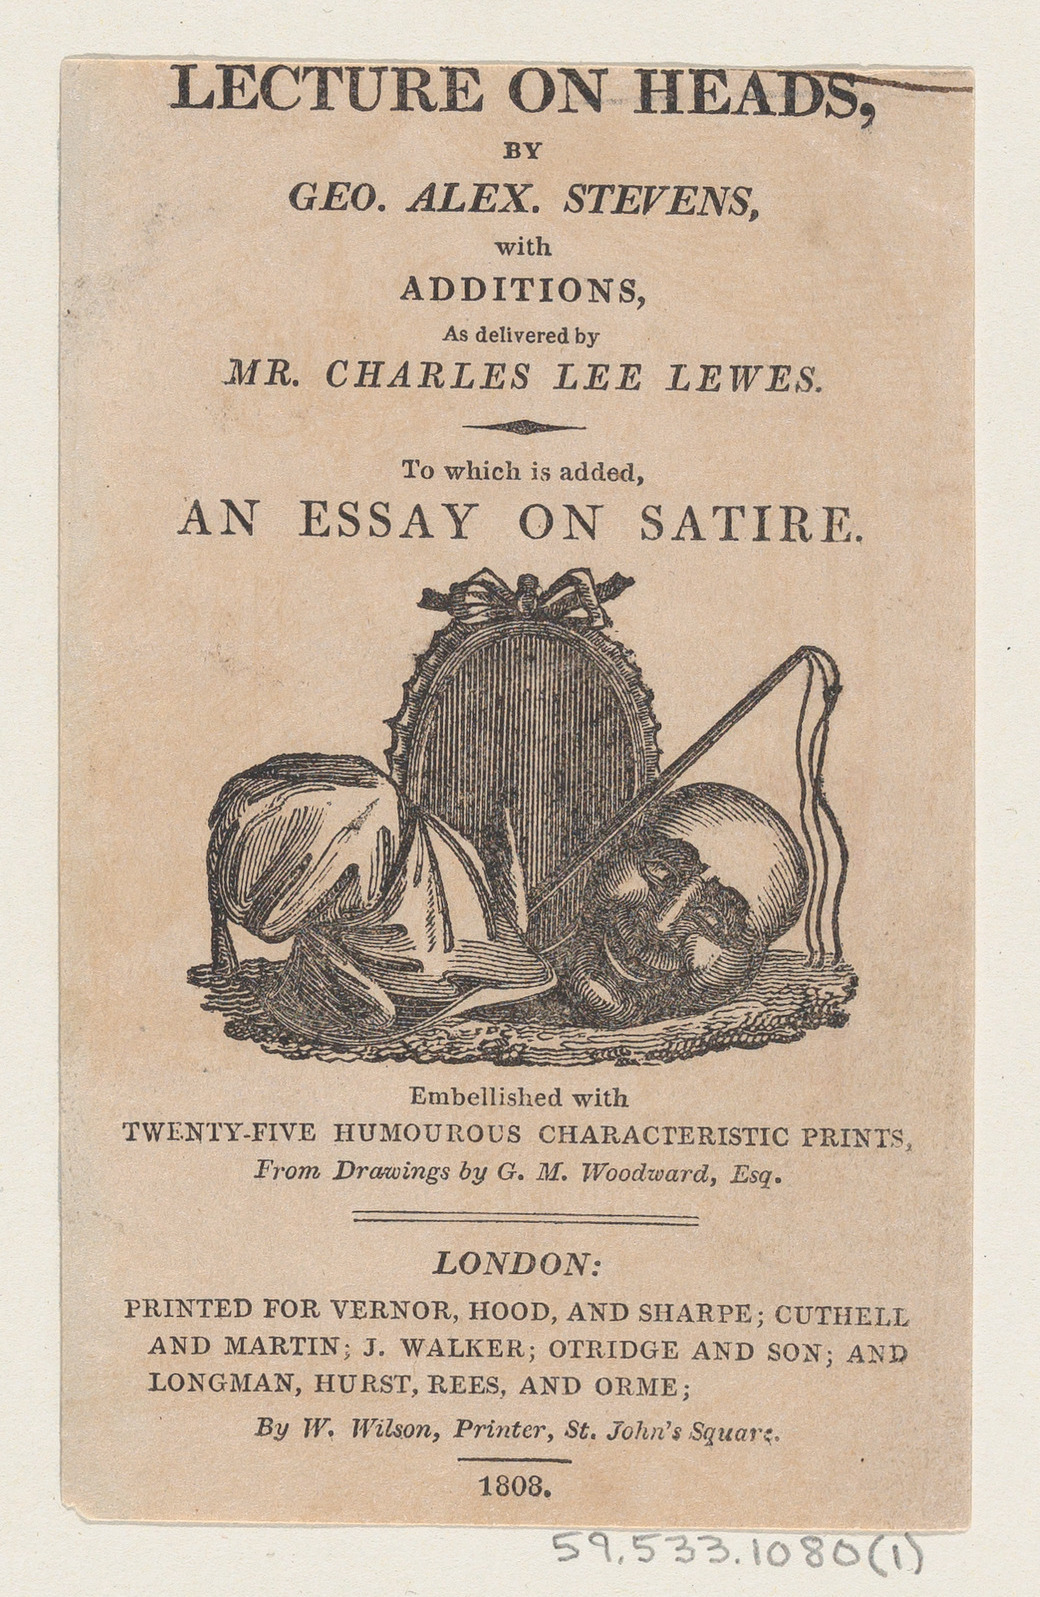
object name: print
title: Title page, from "A Lecture on Heads" by George Alexander Stevens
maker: thomas rowlandson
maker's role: artist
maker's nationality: british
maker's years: 1757-1827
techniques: letterpress, engraving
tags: masks